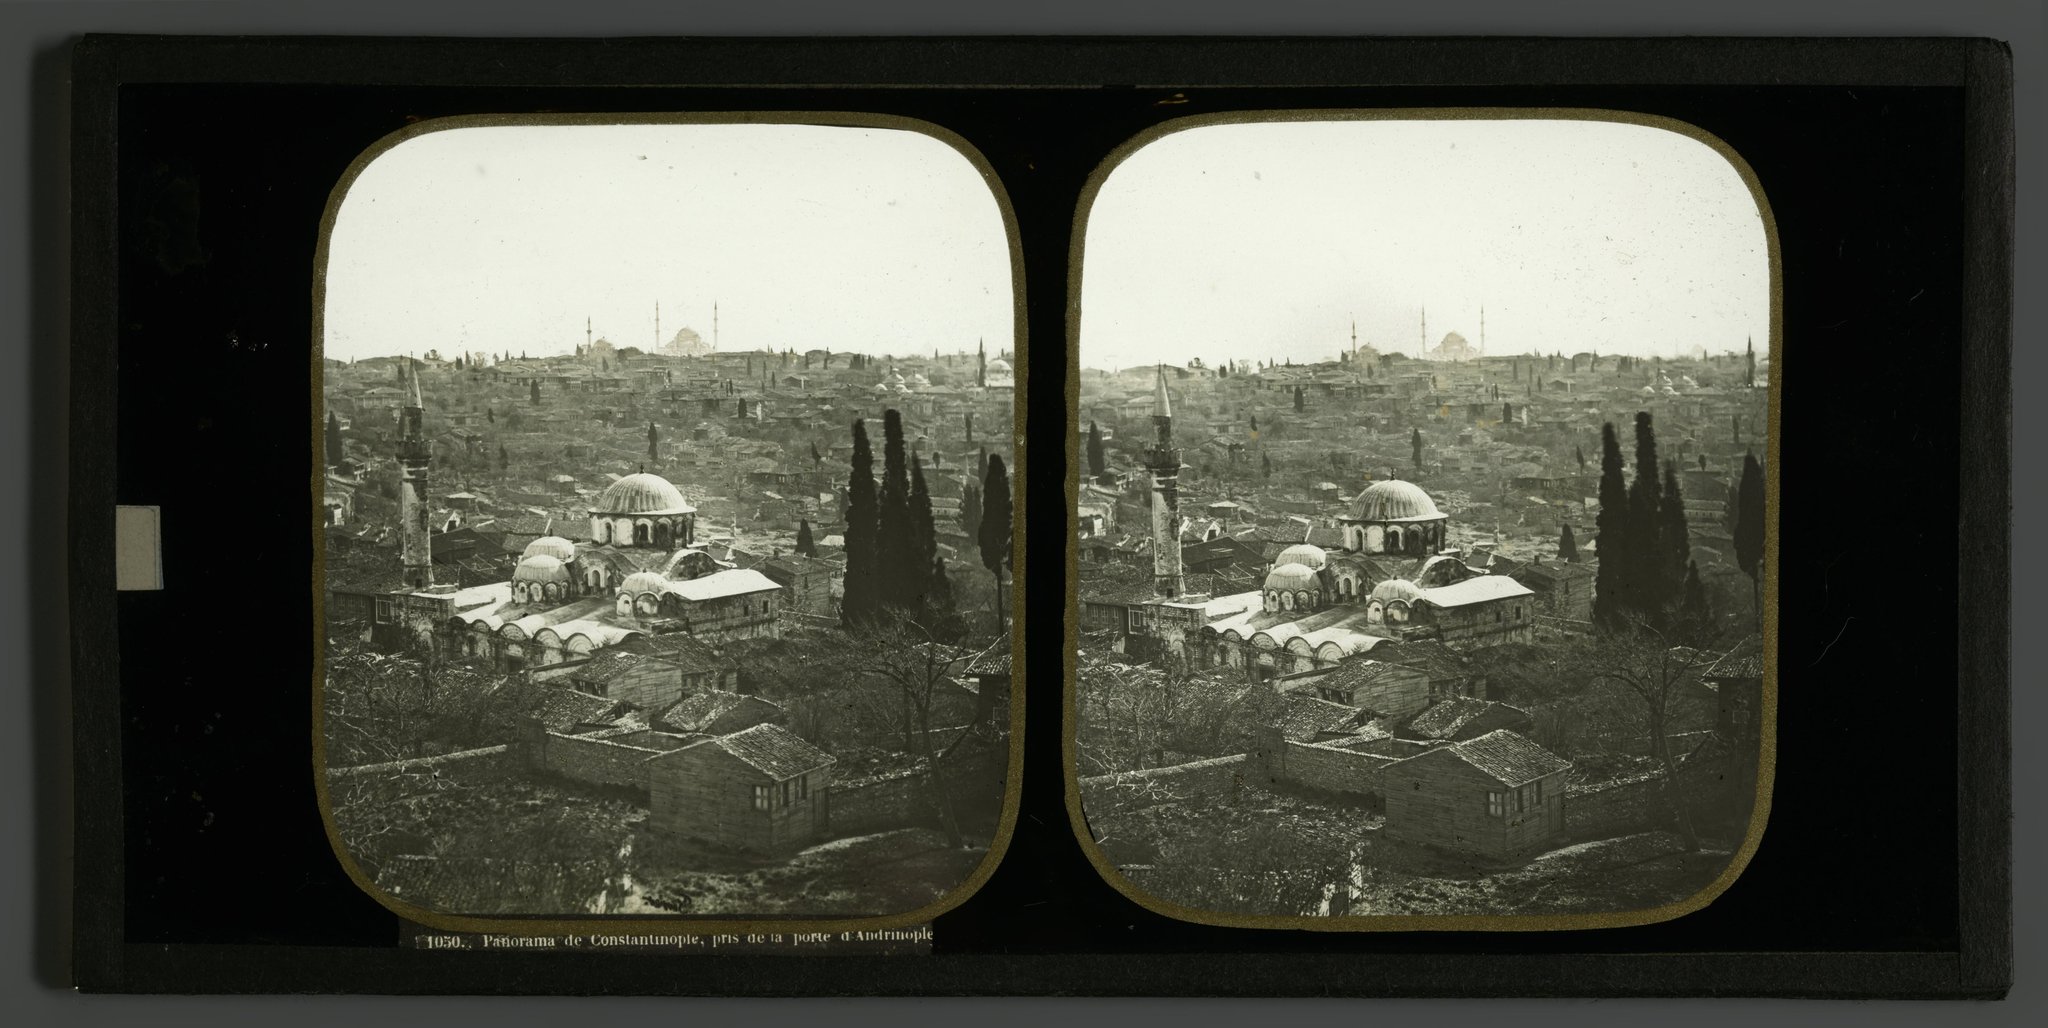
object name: stereoscopic photograph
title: Panorama de Constantinople, pris de la porte d'Andrinople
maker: Anonymous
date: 1860-1890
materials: glass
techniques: slide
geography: istanbul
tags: city-view in general; 'veduta', exterior ~ representation of a building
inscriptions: number: ‘1050’